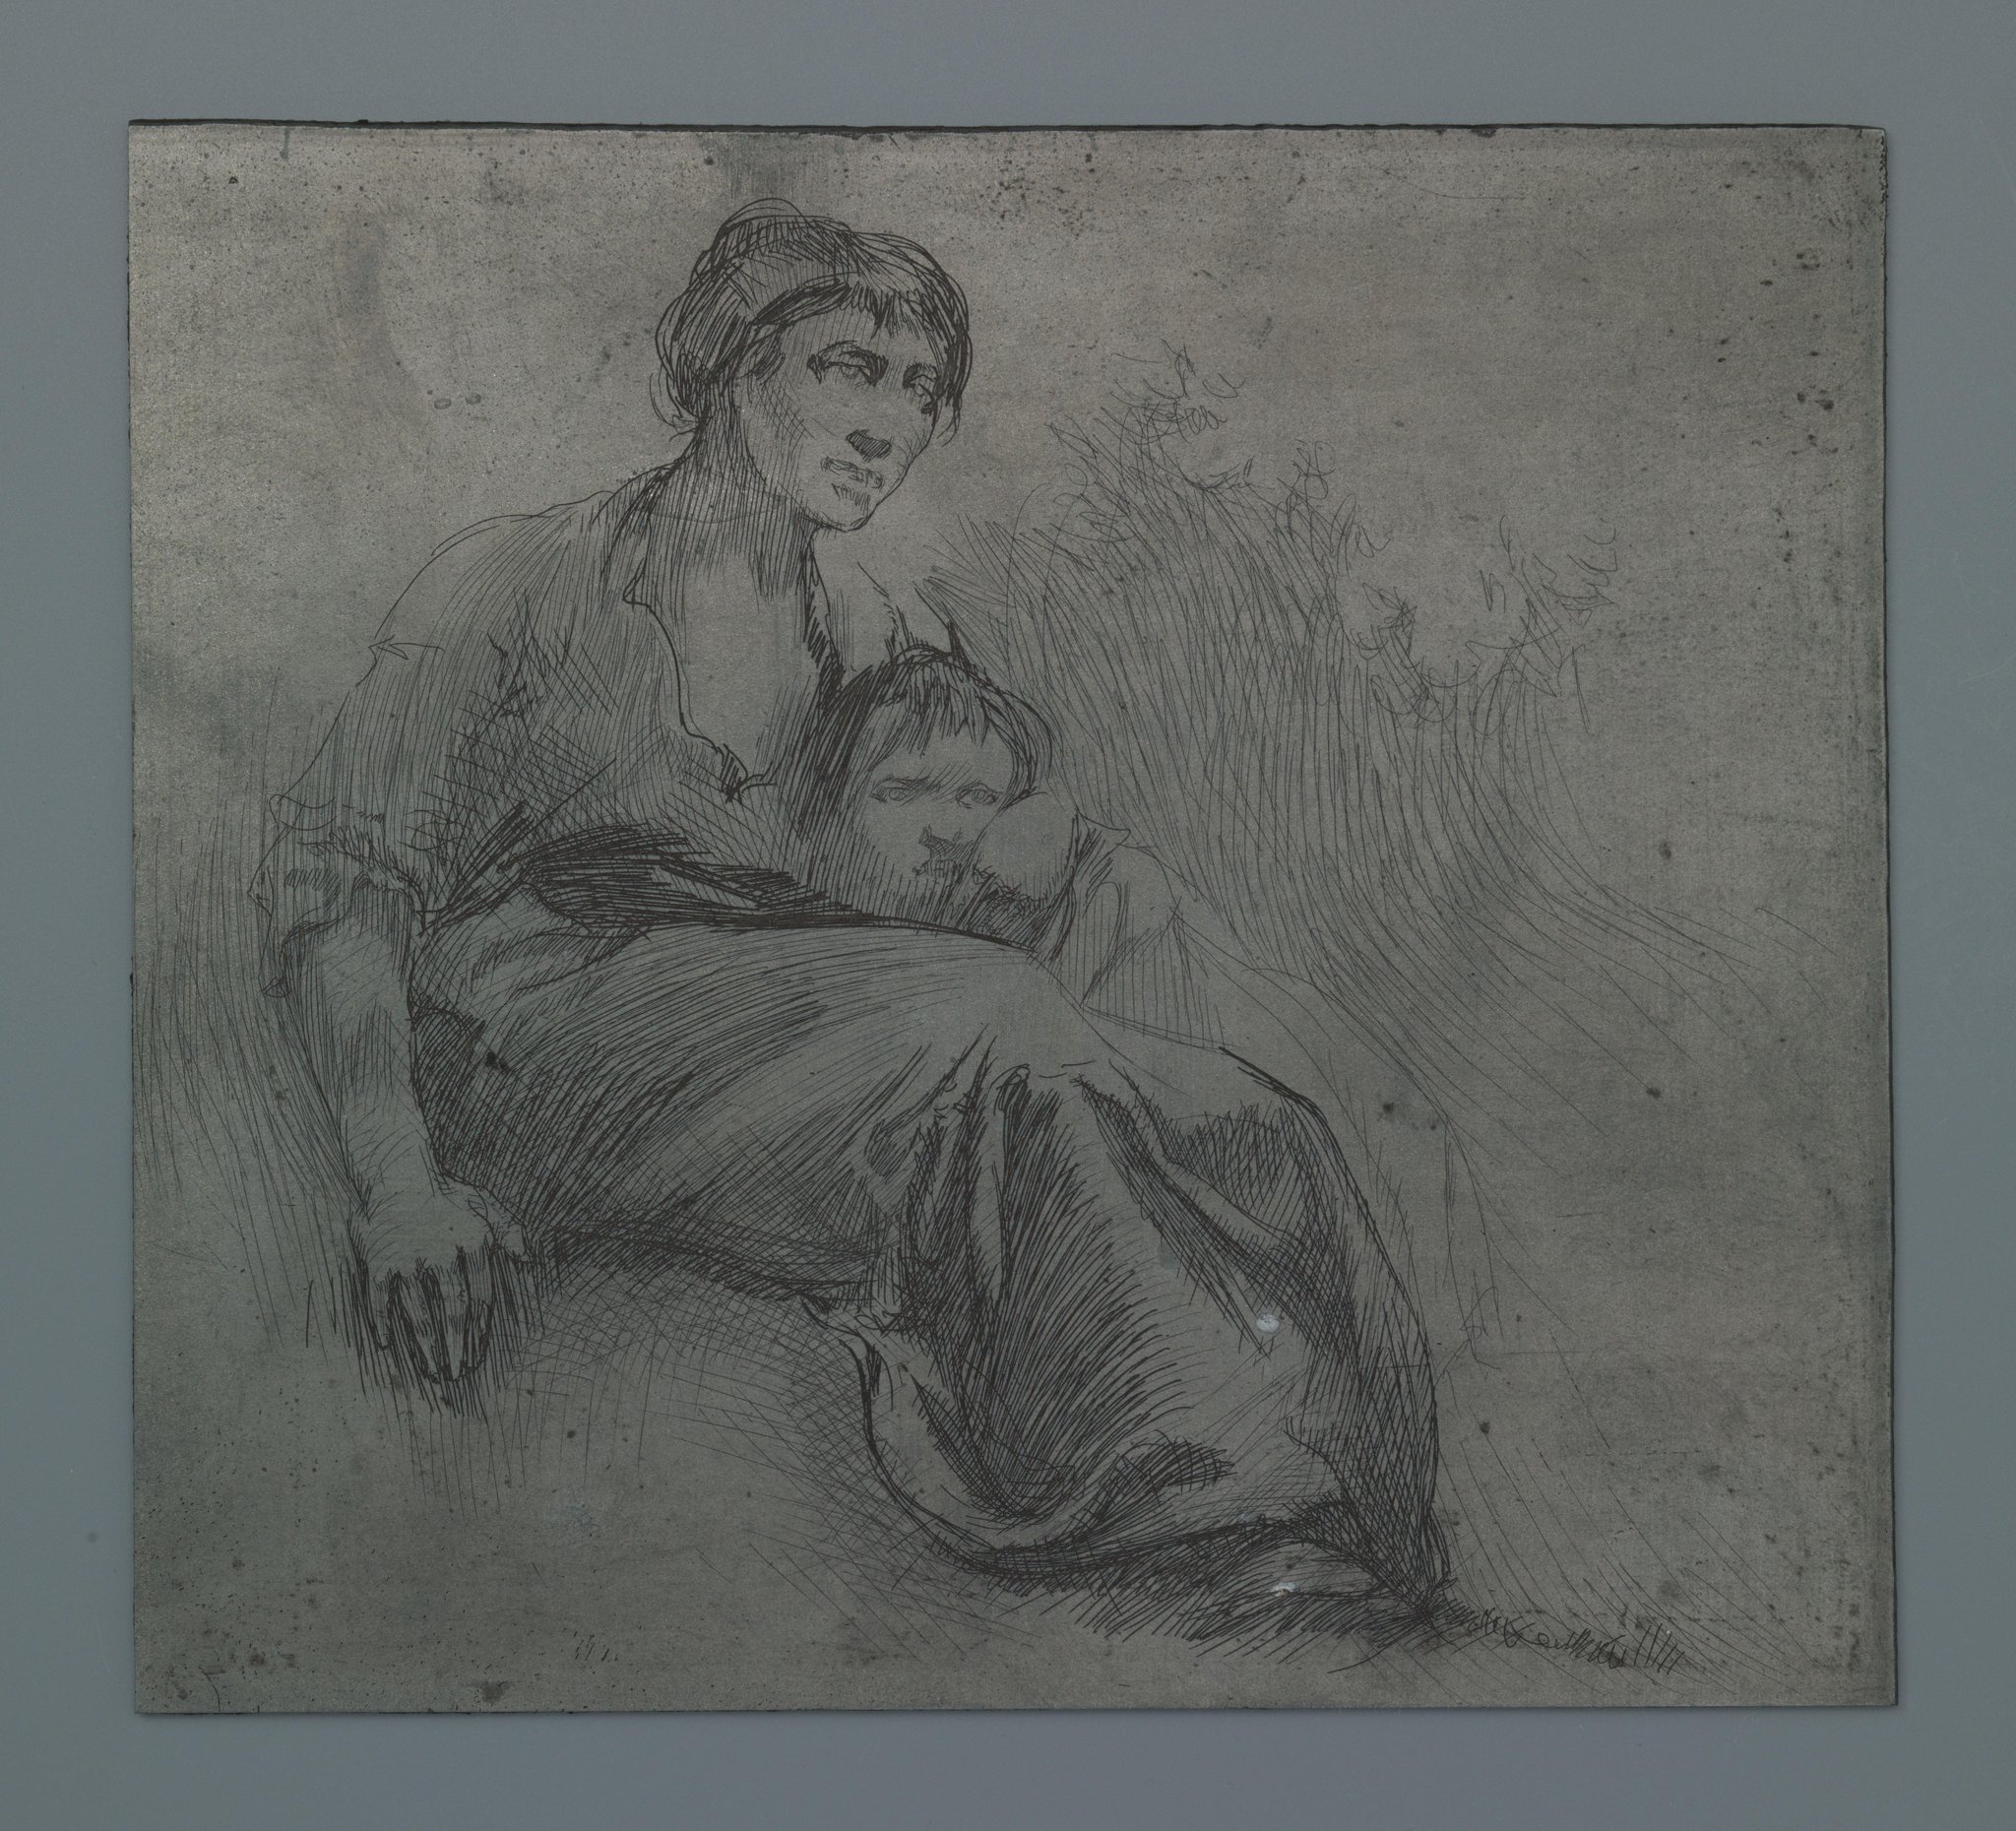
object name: zinkplaat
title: Moeder met kind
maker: johannes josephus aarts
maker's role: draughtsman, print maker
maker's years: 1871-1934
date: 1881-1934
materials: zinc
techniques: etching